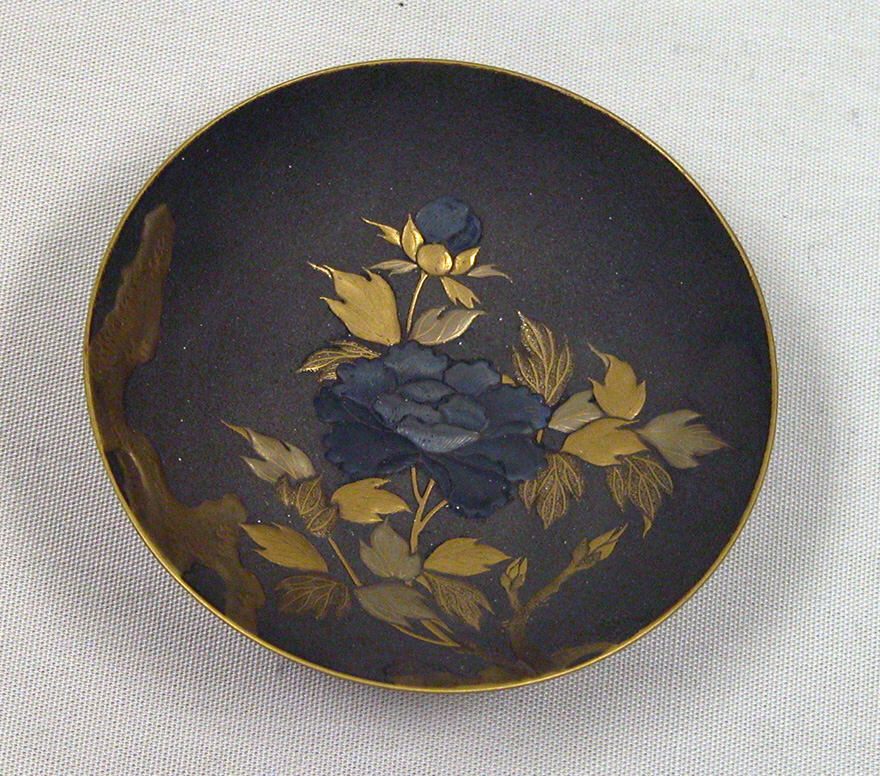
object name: wine cup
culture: japanese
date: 1801-1900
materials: gold, lacquer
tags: flowers,leaves